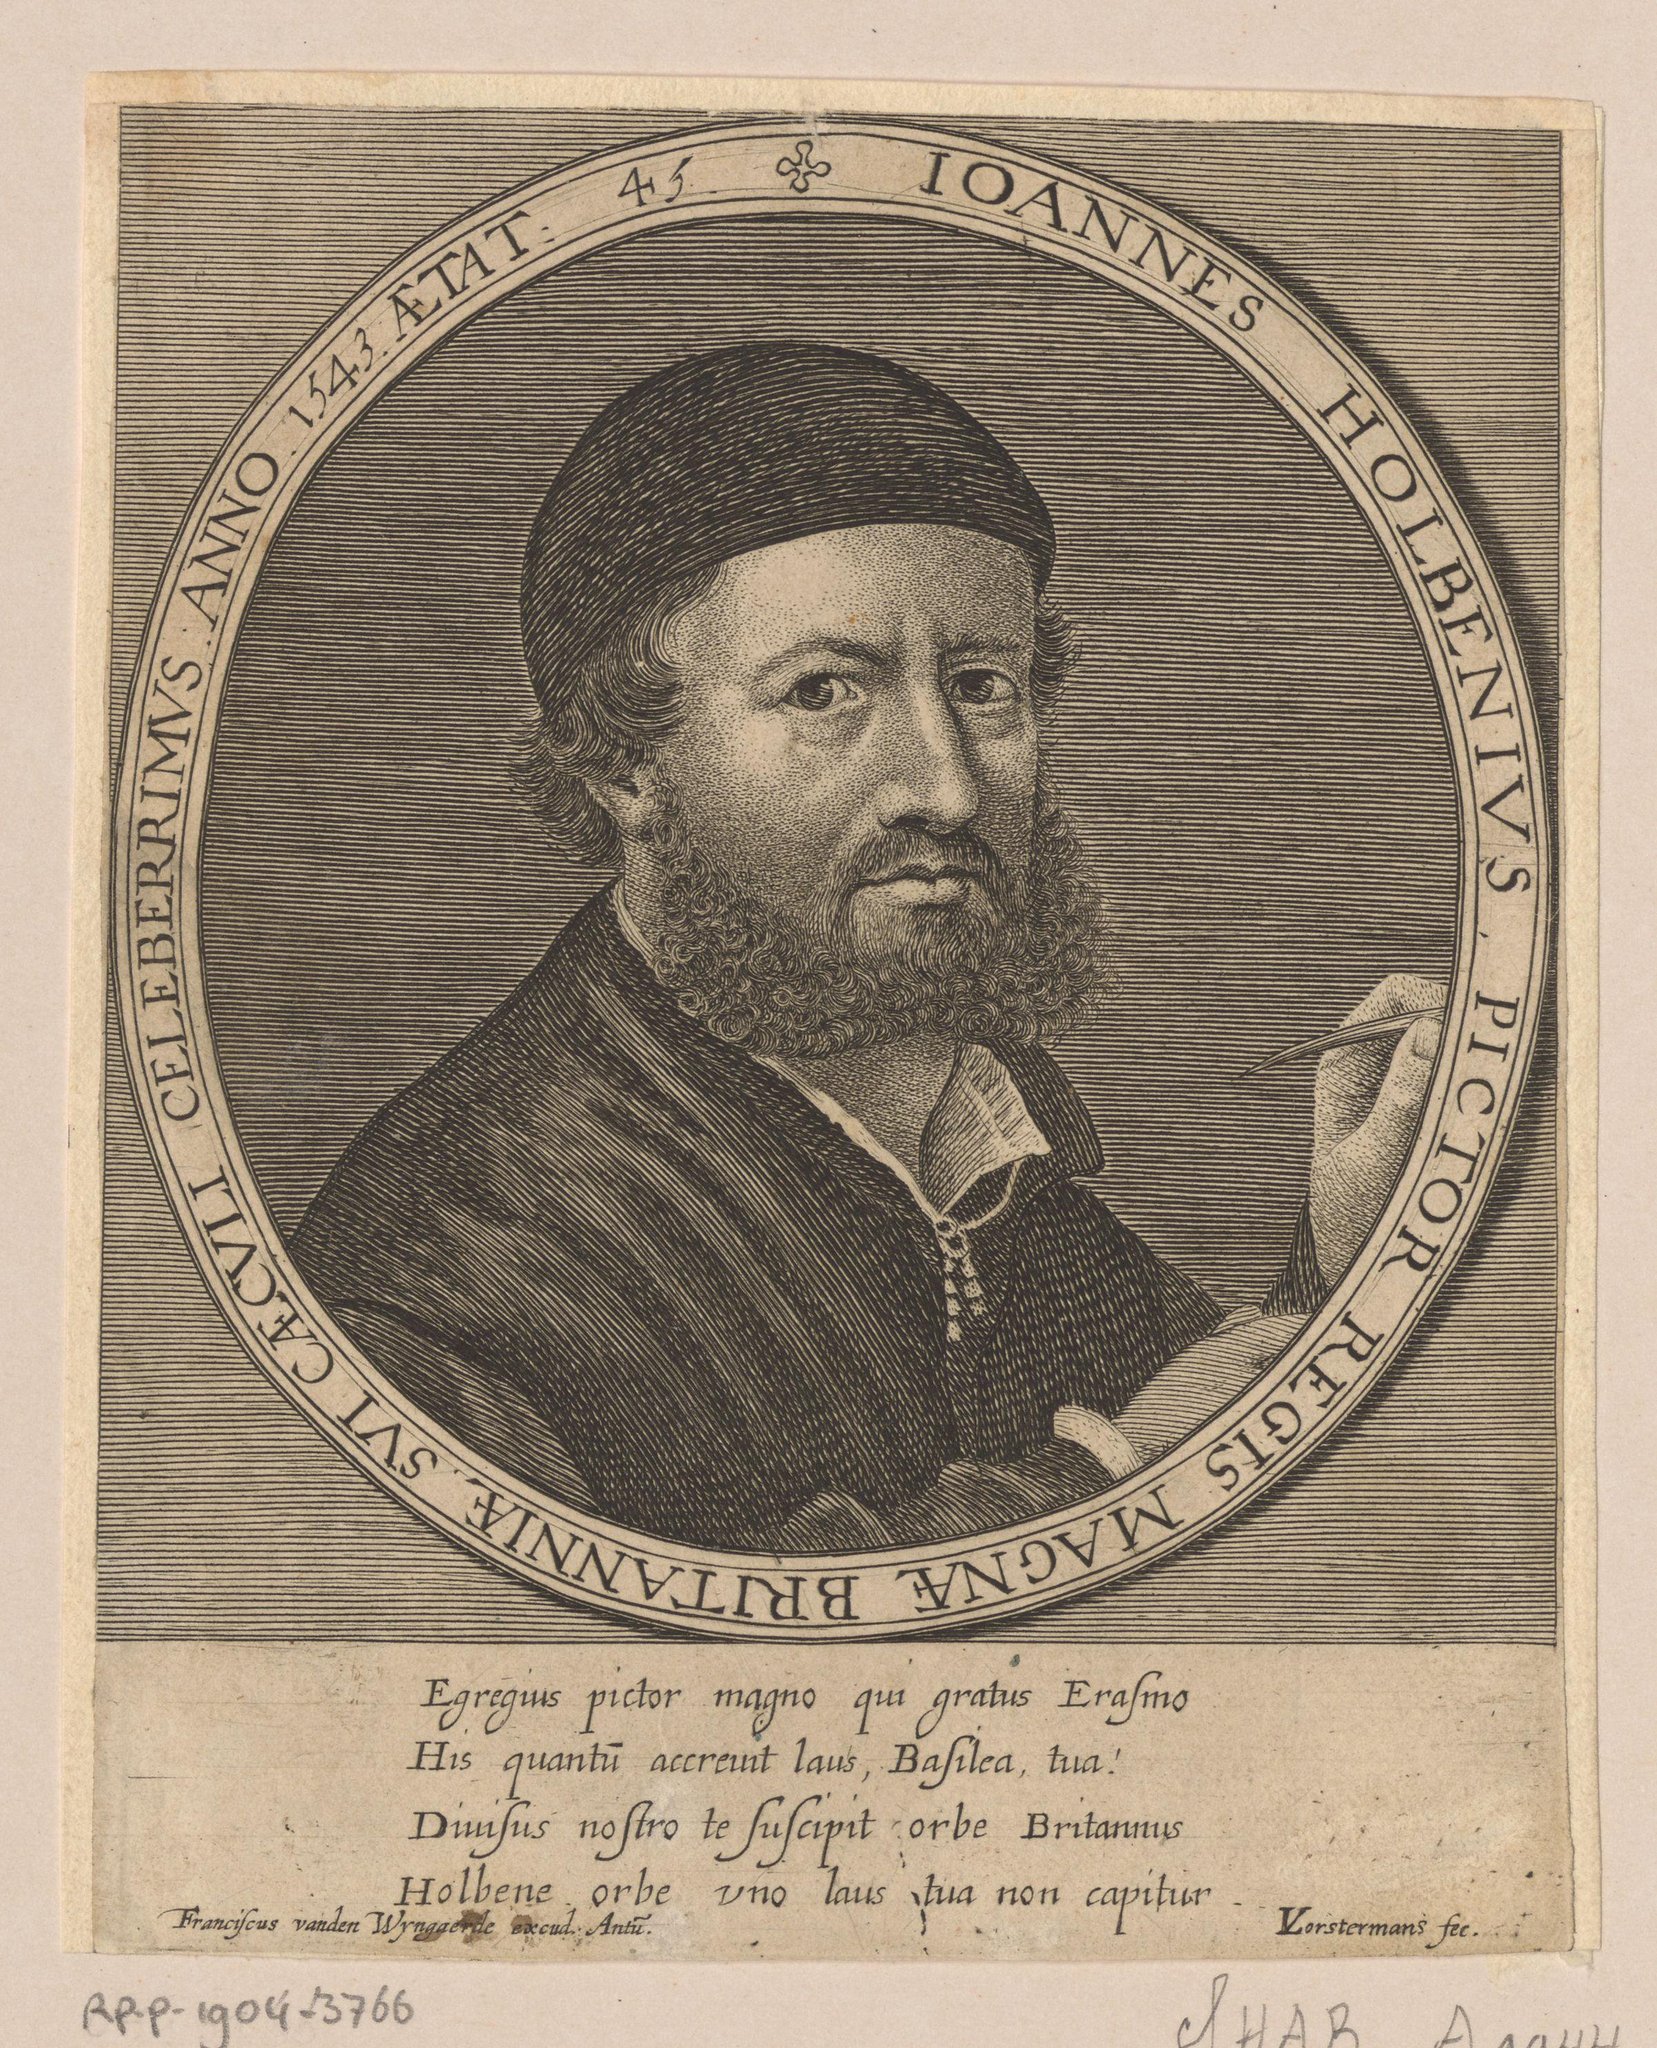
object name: print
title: Portret van Hans Holbein II op 45-jarige leeftijd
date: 1624-1679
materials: paper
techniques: engraving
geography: antwerp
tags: augsburg, london, painter, draughtsman, hans holbein (ii), historical persons, portrait, self-portrait of painter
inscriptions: collector's mark: Lugt 2228, inscription: ‘[...] 167’